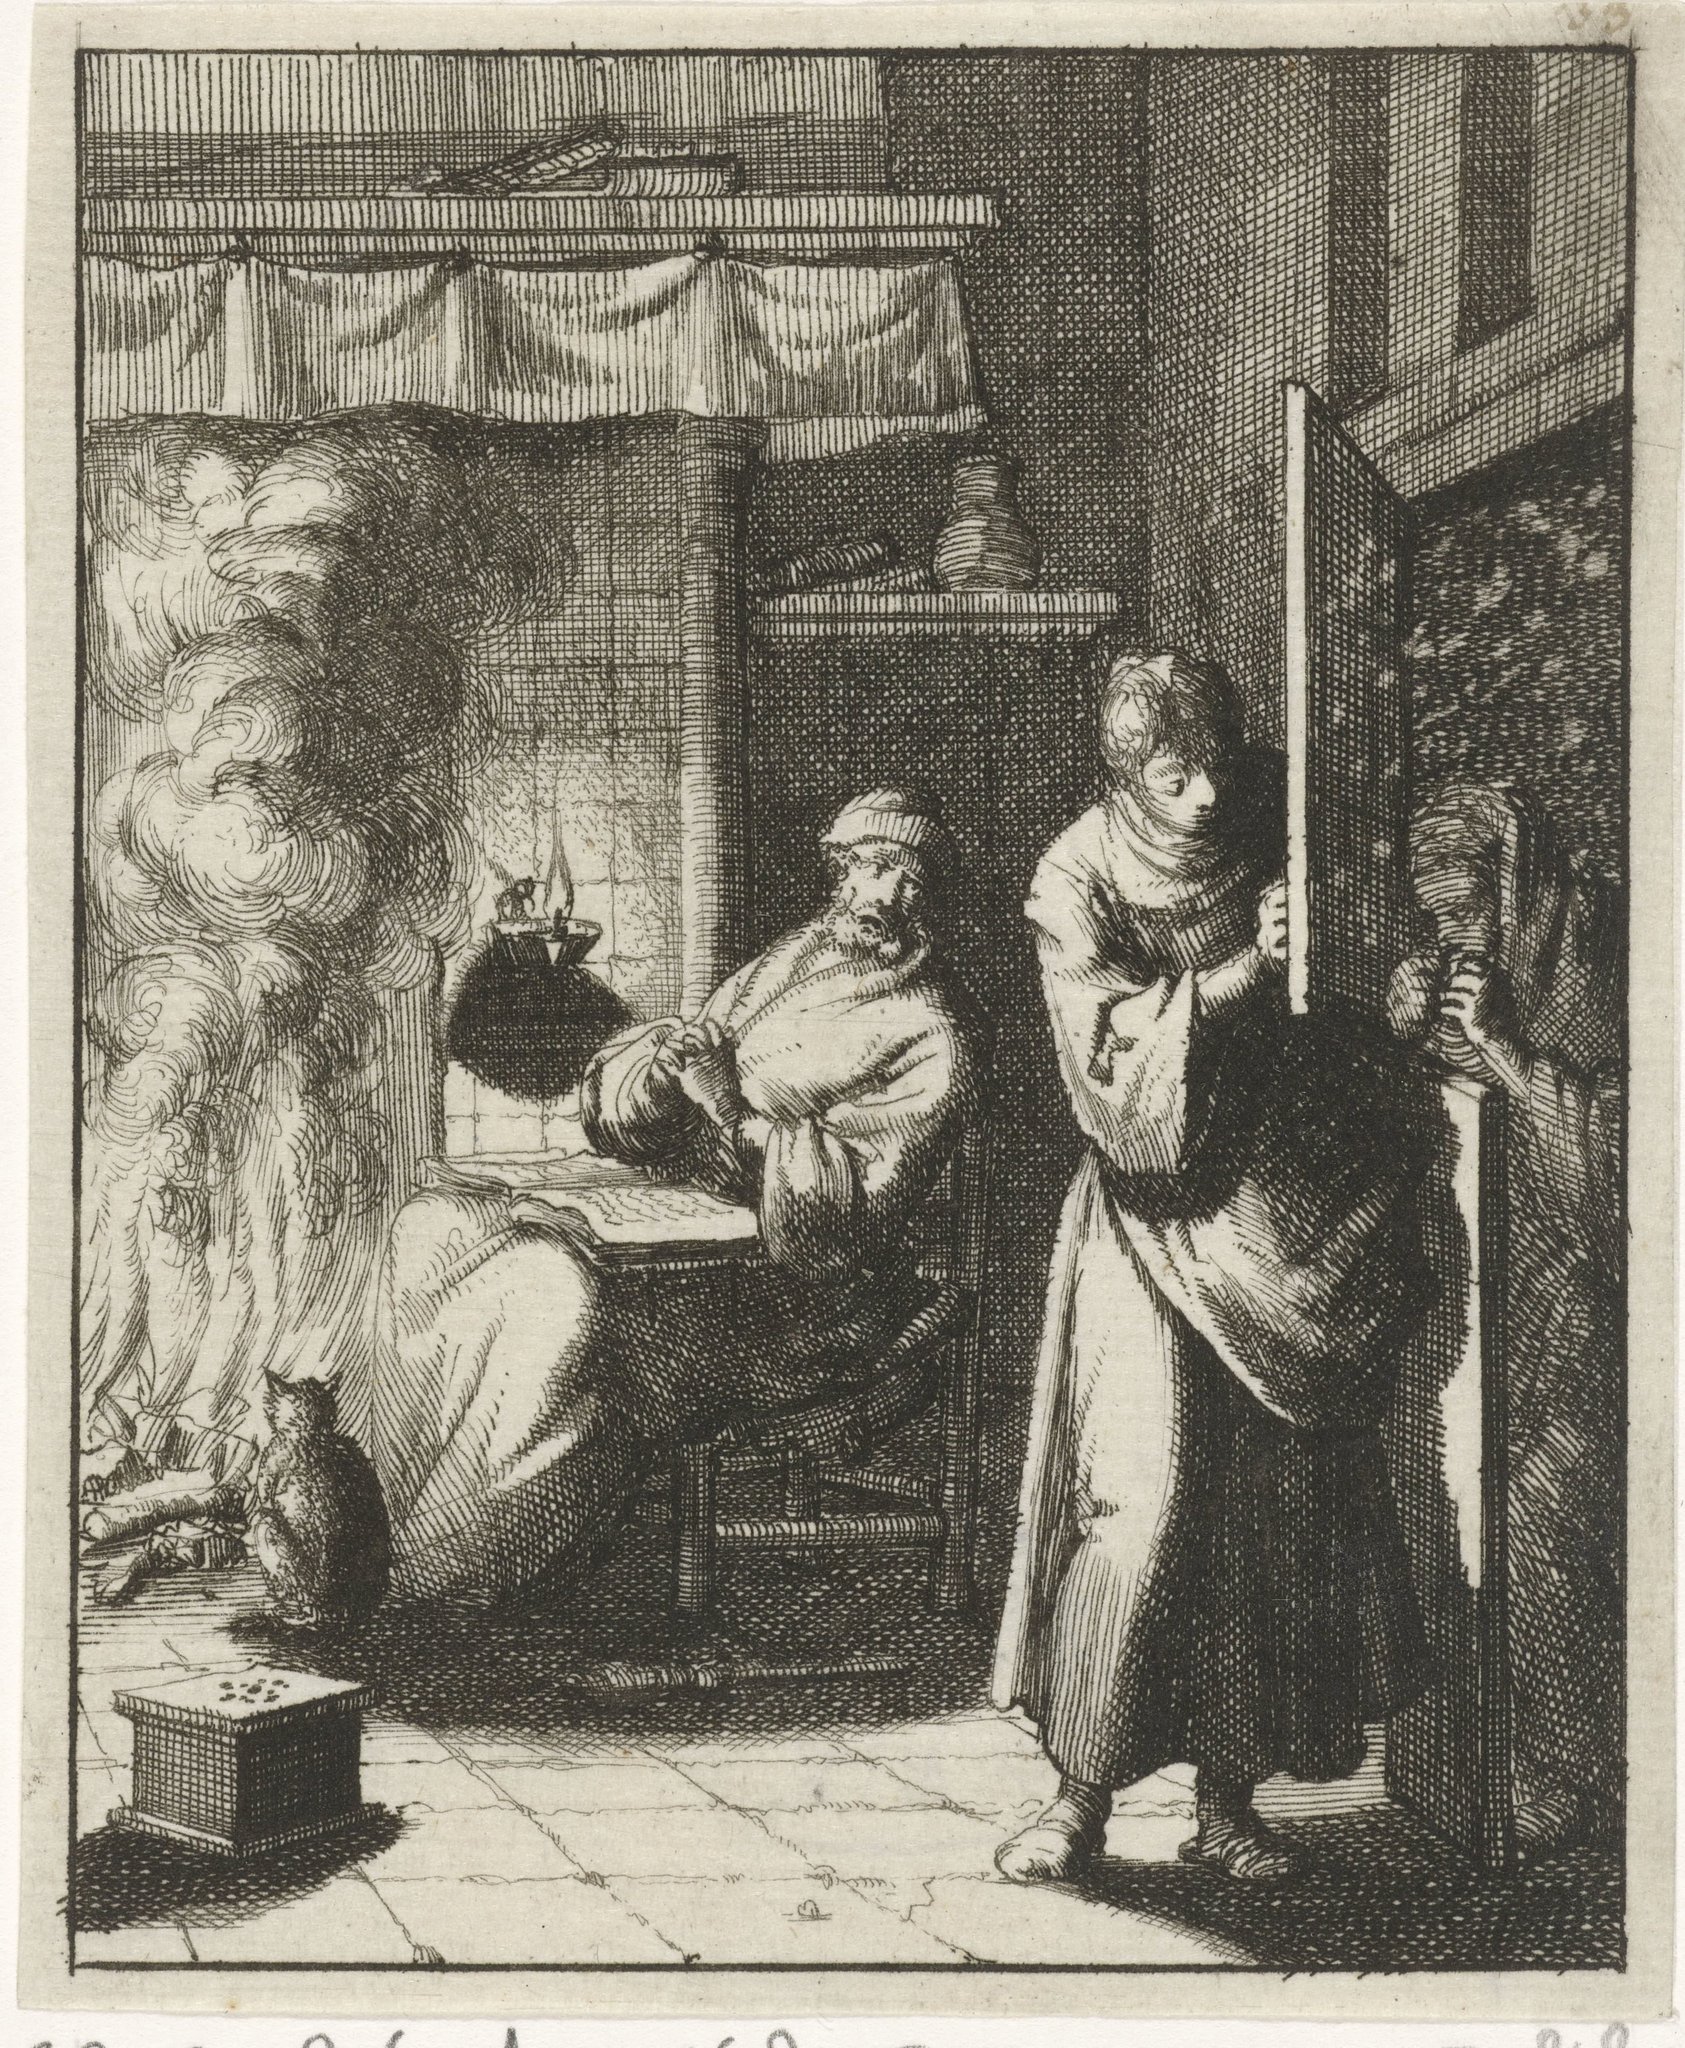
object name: print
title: Als 't buyten woedt, Is 't binnen soet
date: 1687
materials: paper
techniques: etching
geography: amsterdam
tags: open hearth, fire-place, snow, opening the door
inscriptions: collector's mark: Lugt 2228, number: ‘33’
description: Illustratie uit: Luyken, Jan. Voncken der liefde Jesu, van het godtbegerende zielenvier. Amsterdam: Pieter Arentsz (II), 1687, p. 136.